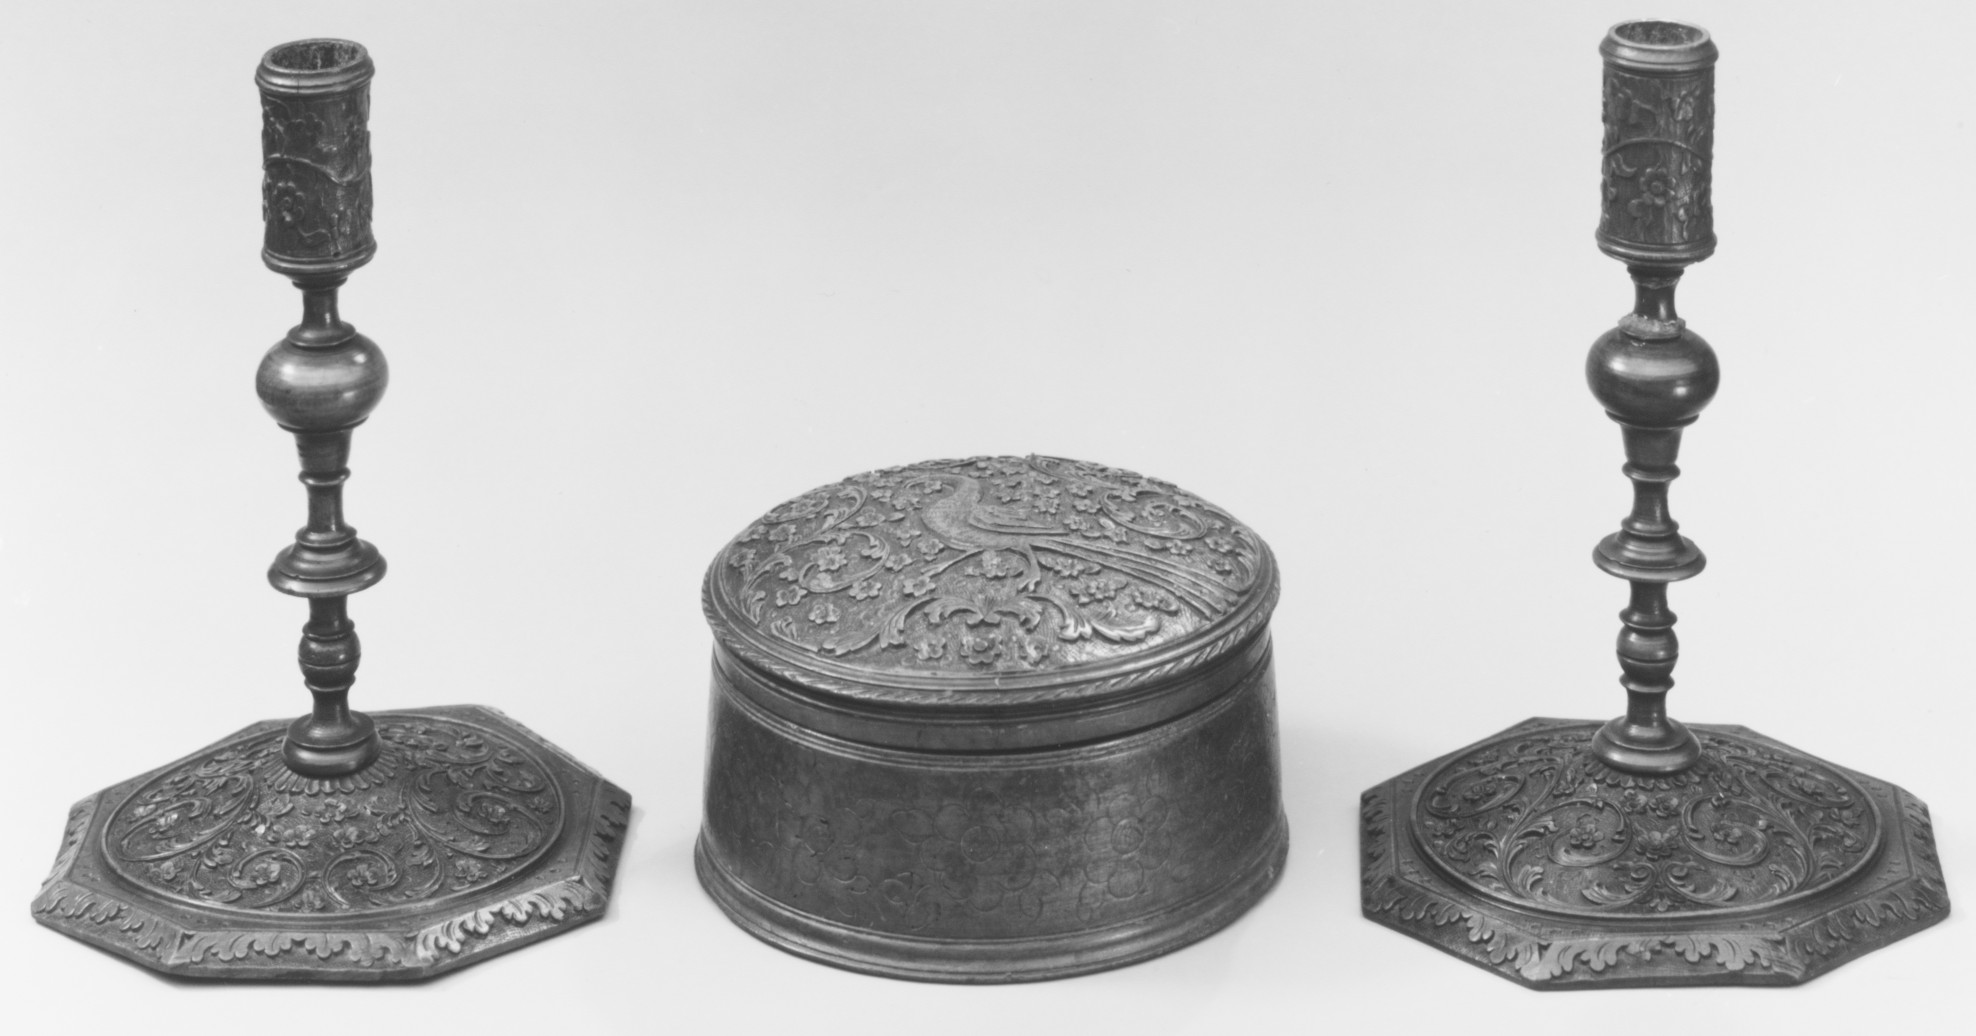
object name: candlestick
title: Pair of candlesticks (part of a set)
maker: nicolas françois foulon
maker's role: maker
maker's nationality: french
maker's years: 1628-1698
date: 1667-1733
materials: wood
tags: birds